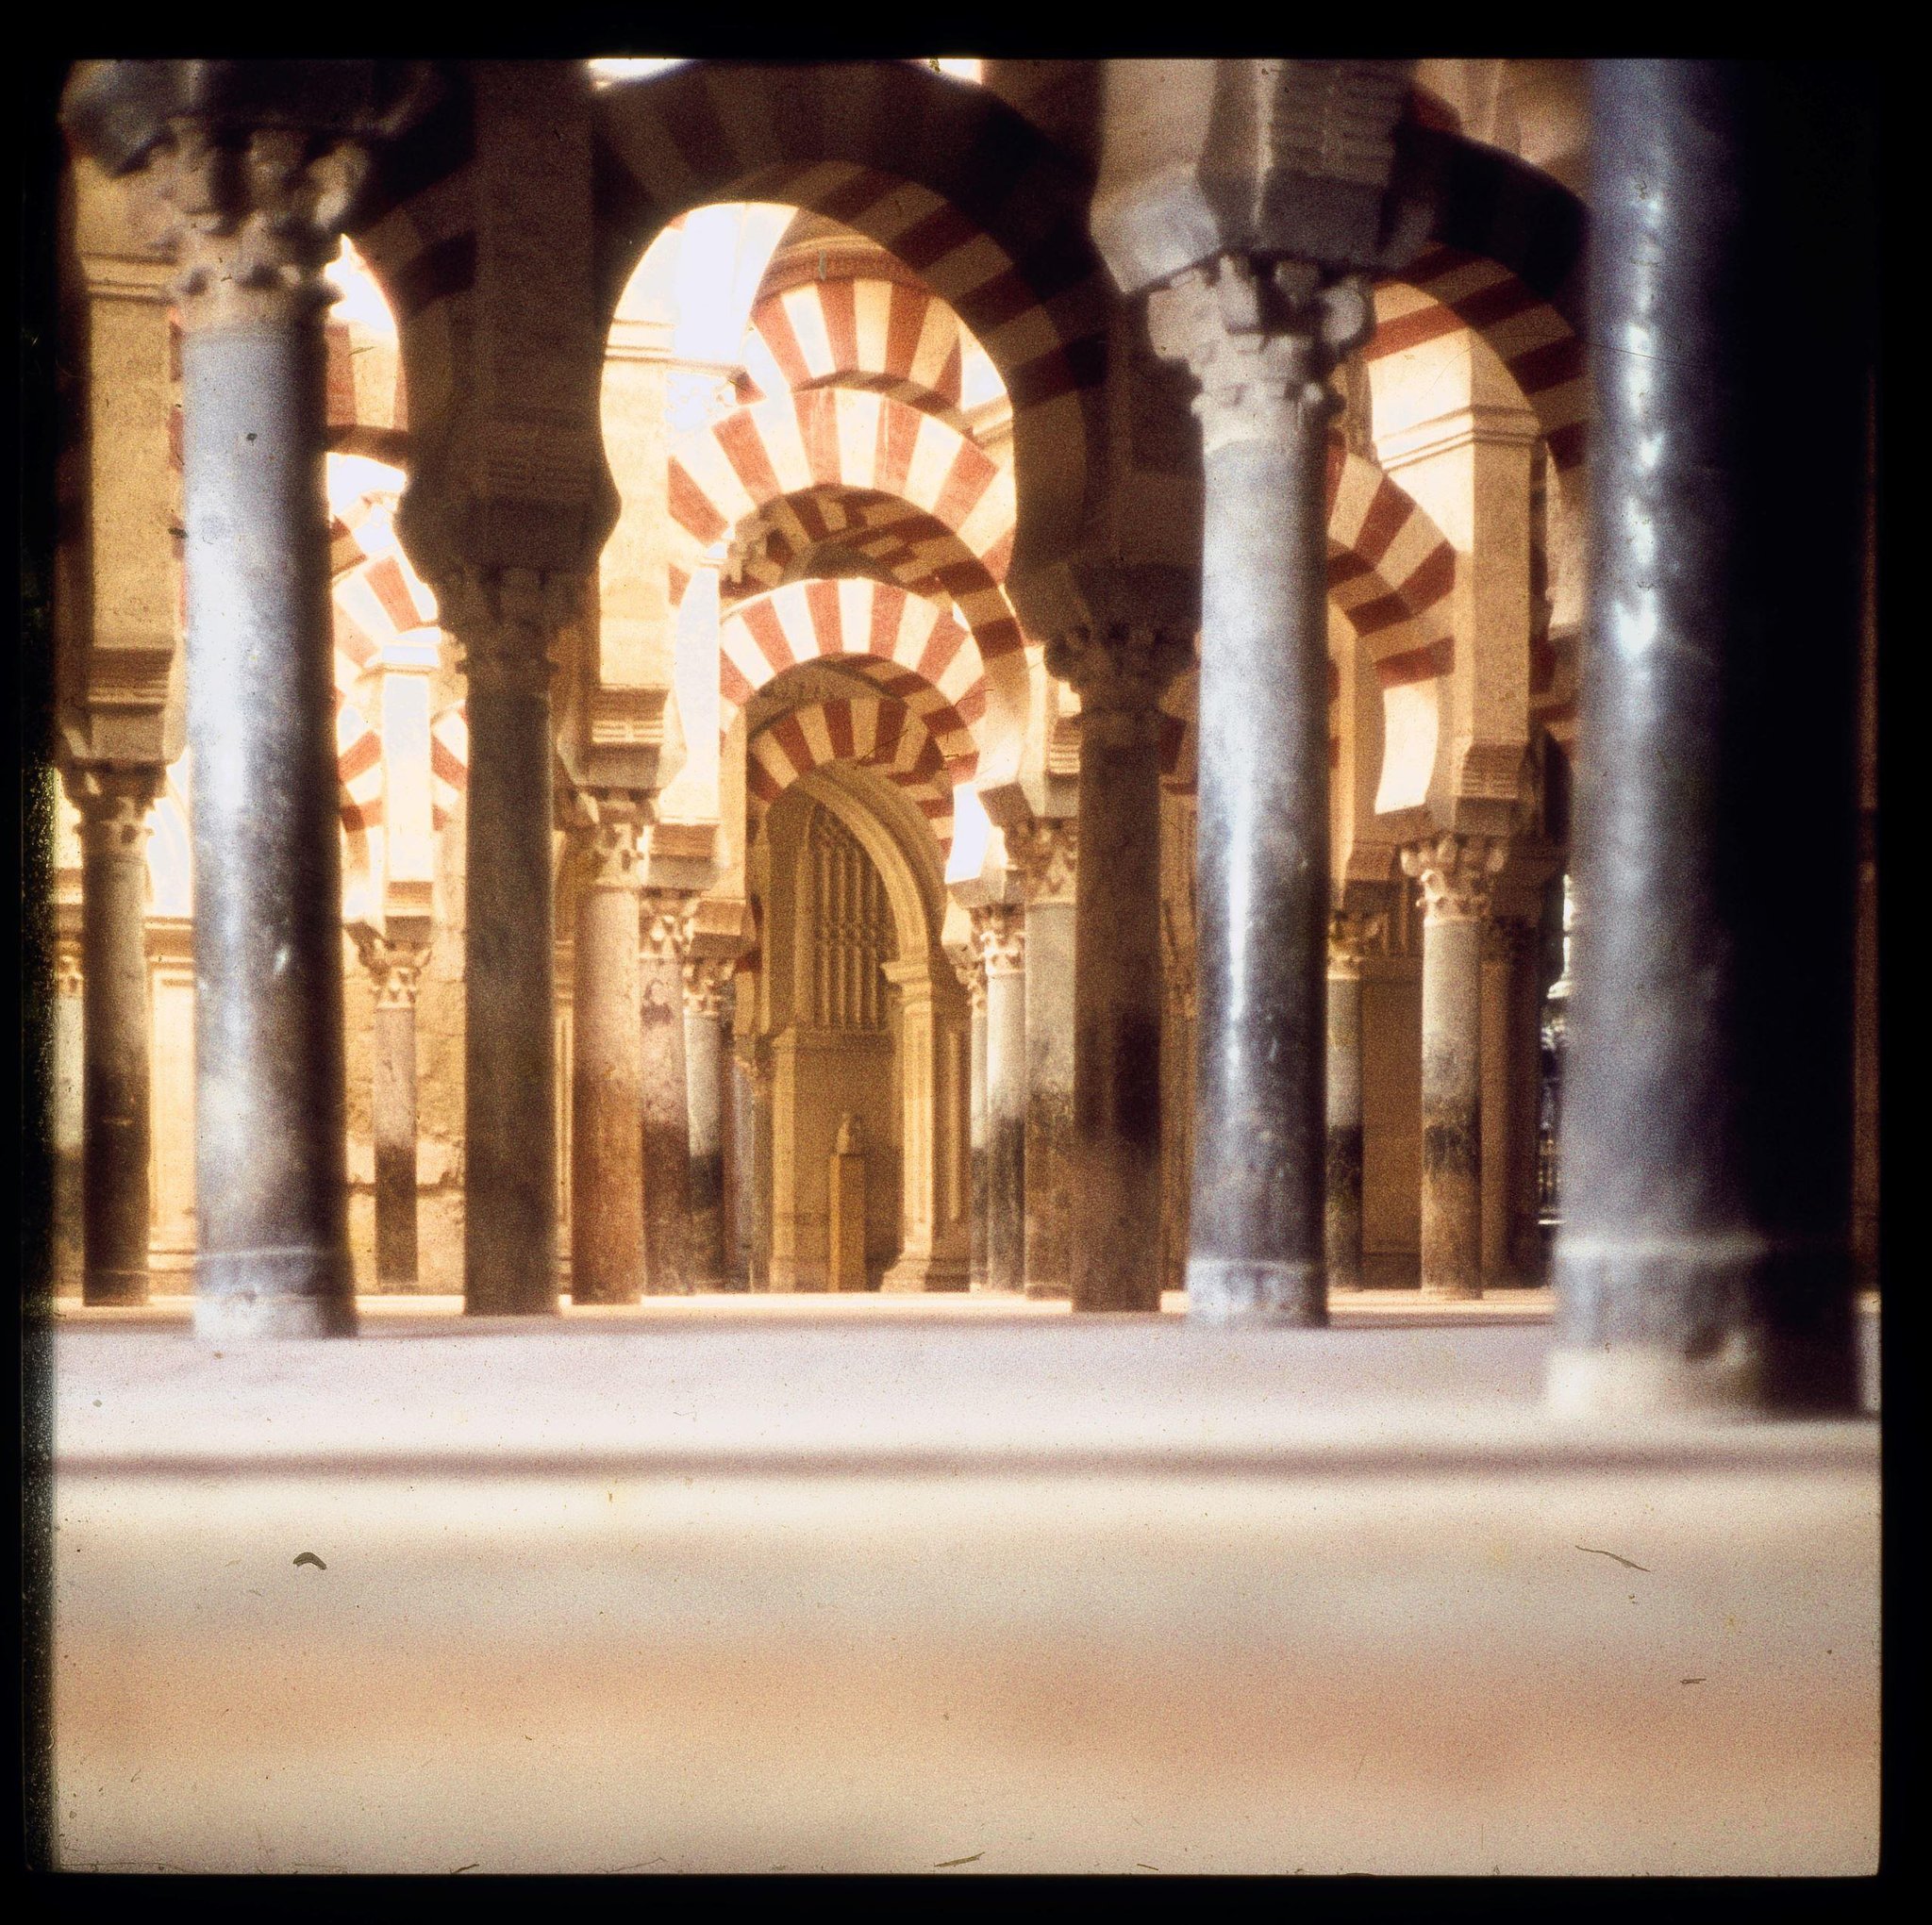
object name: photograph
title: Interieur van een gebouw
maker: Anonymous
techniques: slide